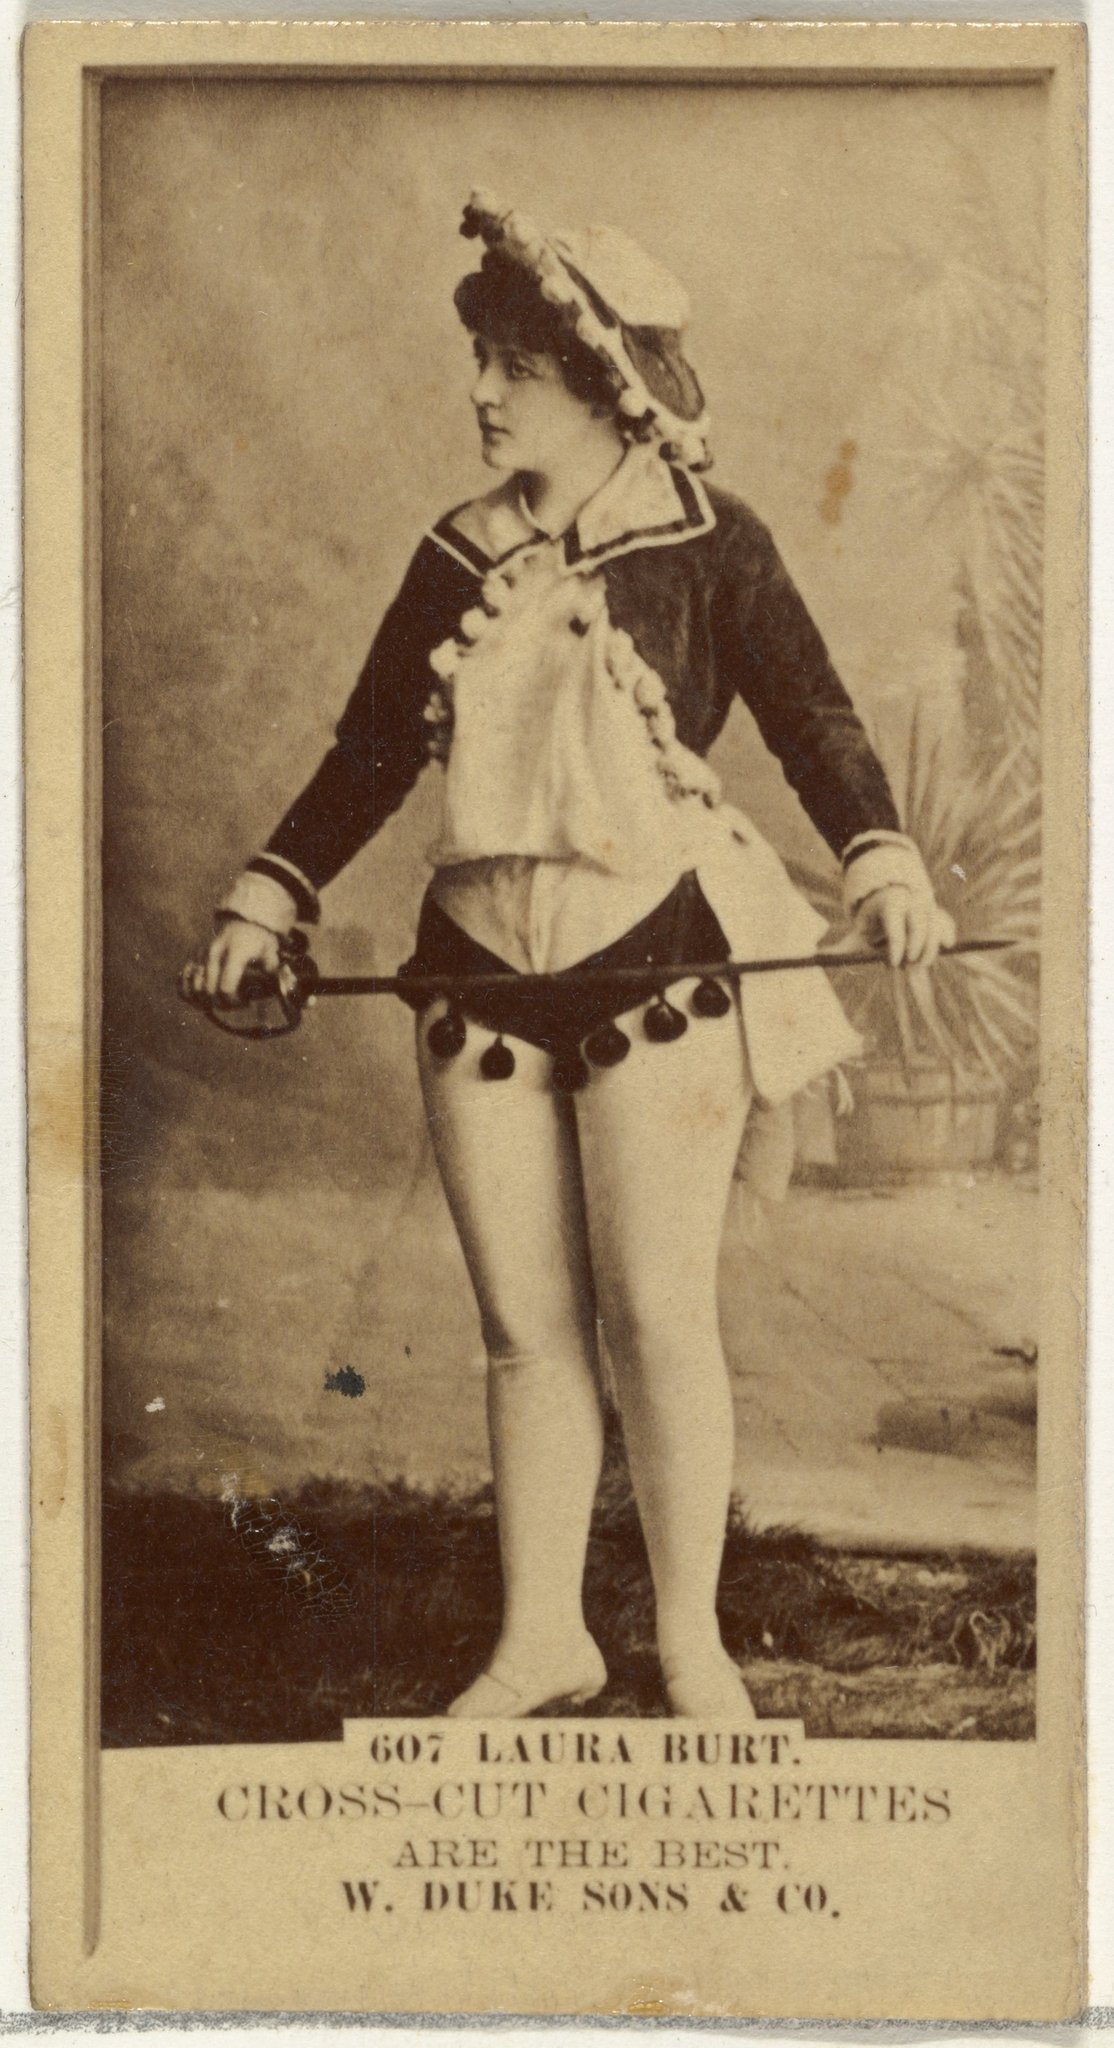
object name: photograph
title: Card Number 607, Laura Burt, from the Actors and Actresses series (N145-3) issued by Duke Sons & Co. to promote Cross Cut Cigarettes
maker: w. duke, sons & co.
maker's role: publisher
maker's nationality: american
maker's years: 1870-1920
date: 1880-1889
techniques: albumen silver print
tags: portraits,women,actresses